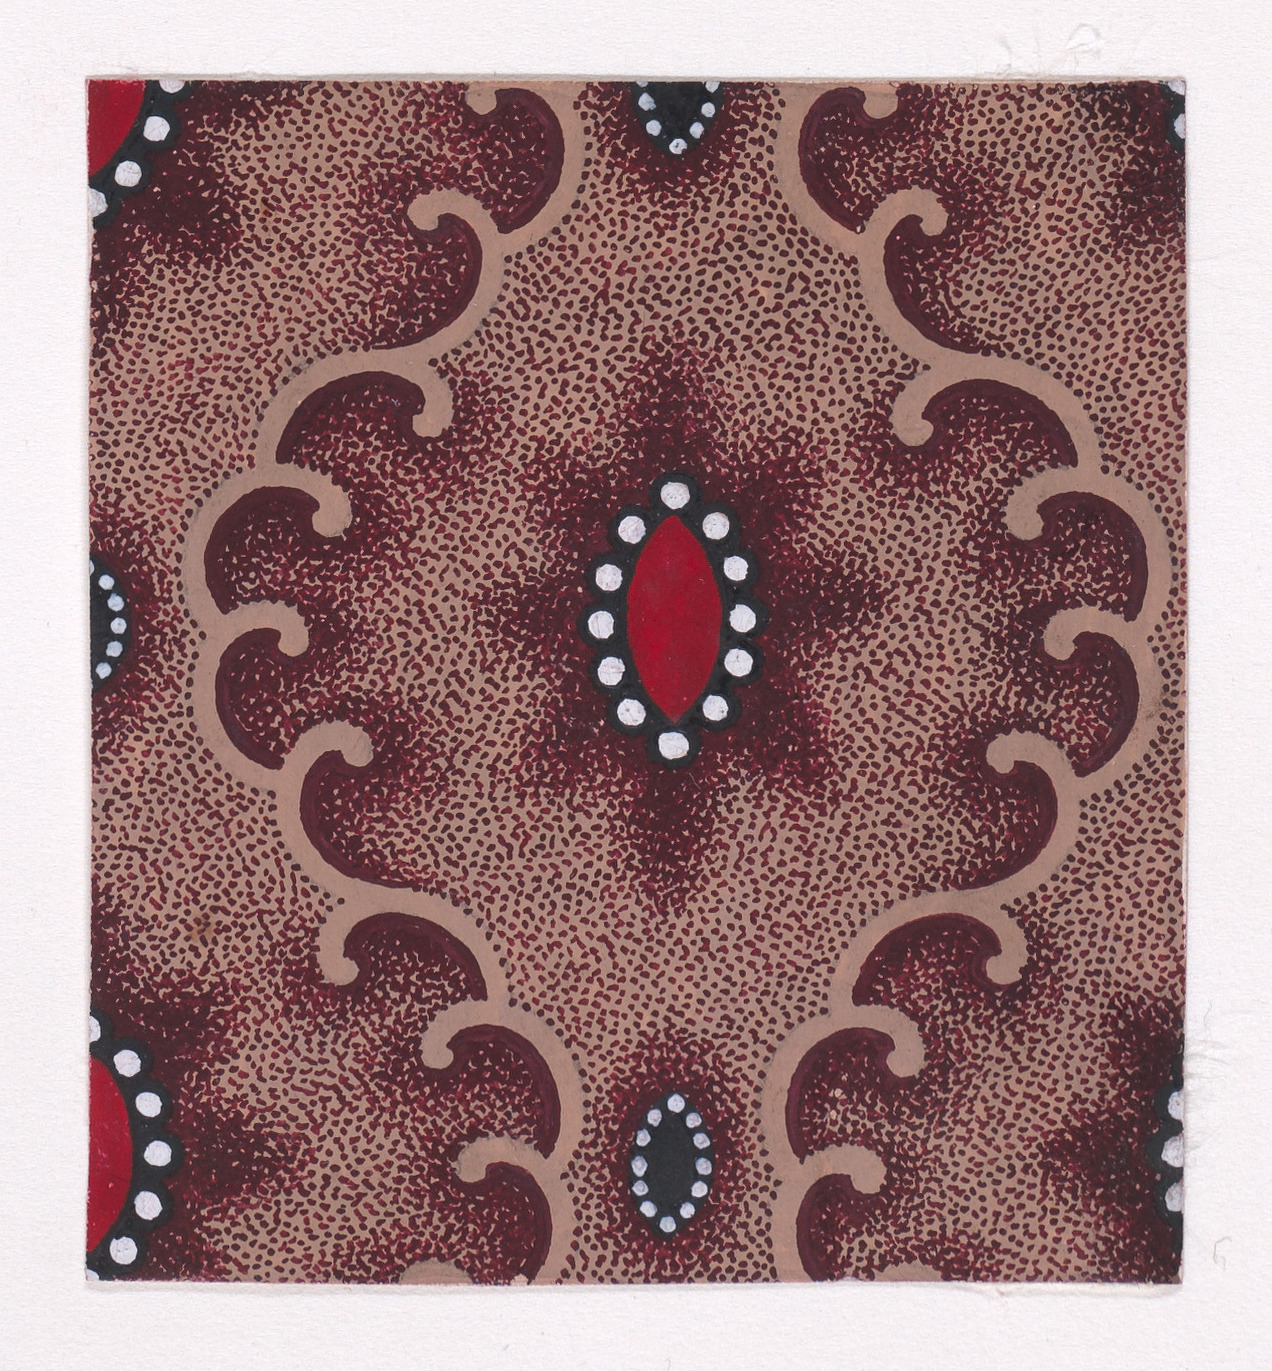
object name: drawing ornament architecture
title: Textile Design with Vertical Rows of Alternating Lenses of Two Different Sizes Bordered by Pearls Separated by Vertical Scrolls of Ribbons Over a Stippled Background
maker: anonymous, alsatian, 19th century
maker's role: artist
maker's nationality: alsatian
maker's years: 1800-1900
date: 1840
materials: gouache